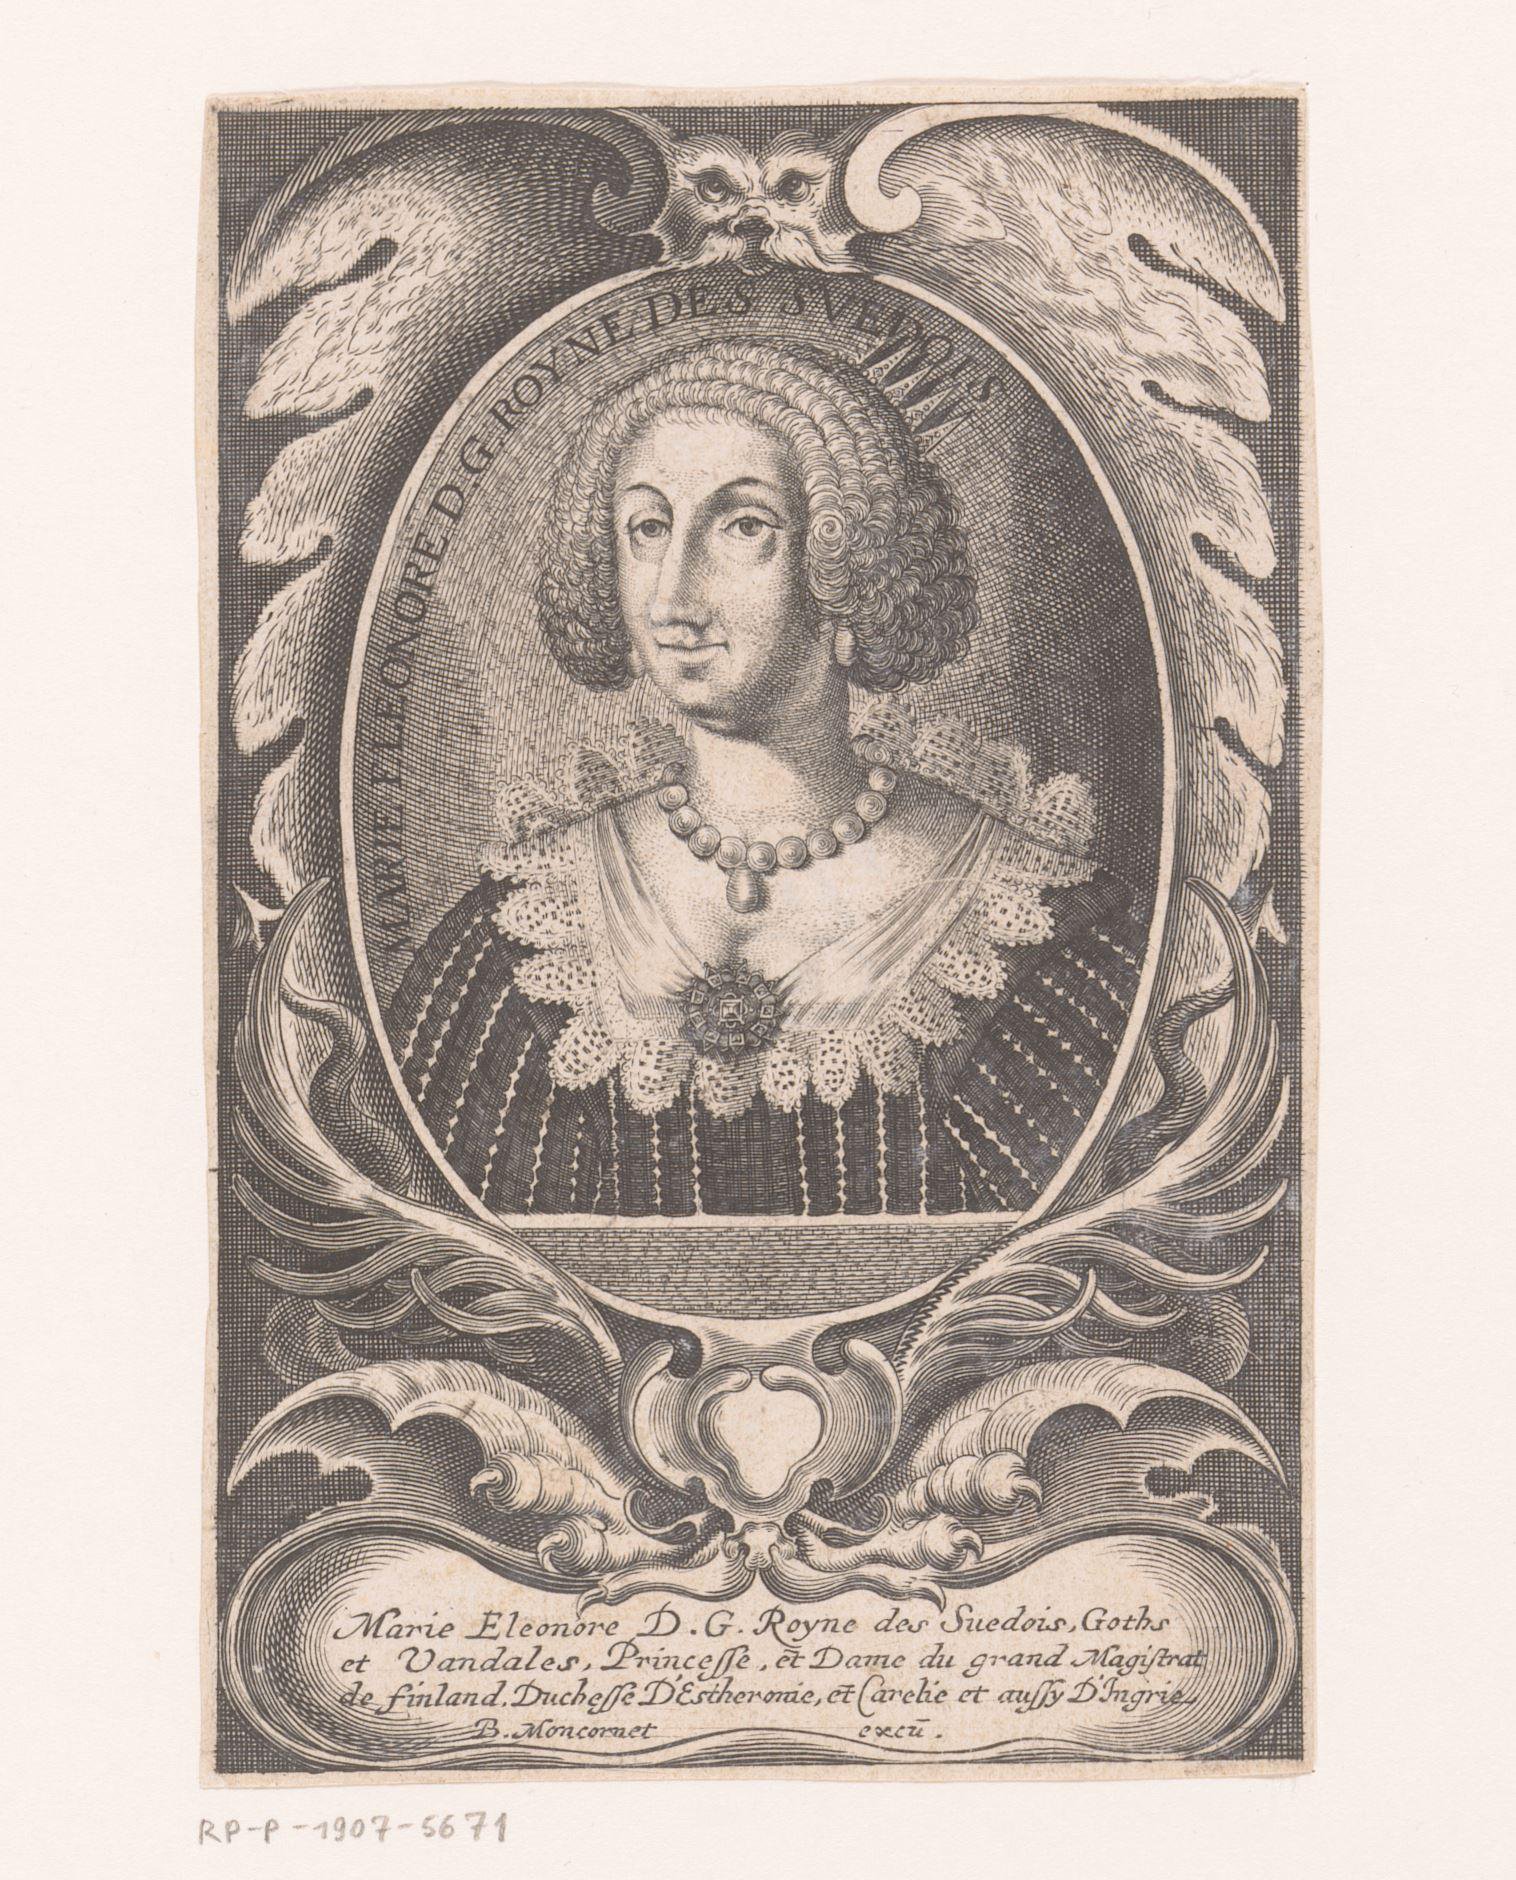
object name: print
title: Portret van Maria Eleonora van Brandenburg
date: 1621-1668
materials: paper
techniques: engraving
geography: paris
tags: historical persons - bb - woman, queen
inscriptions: collector's mark: Lugt 2228